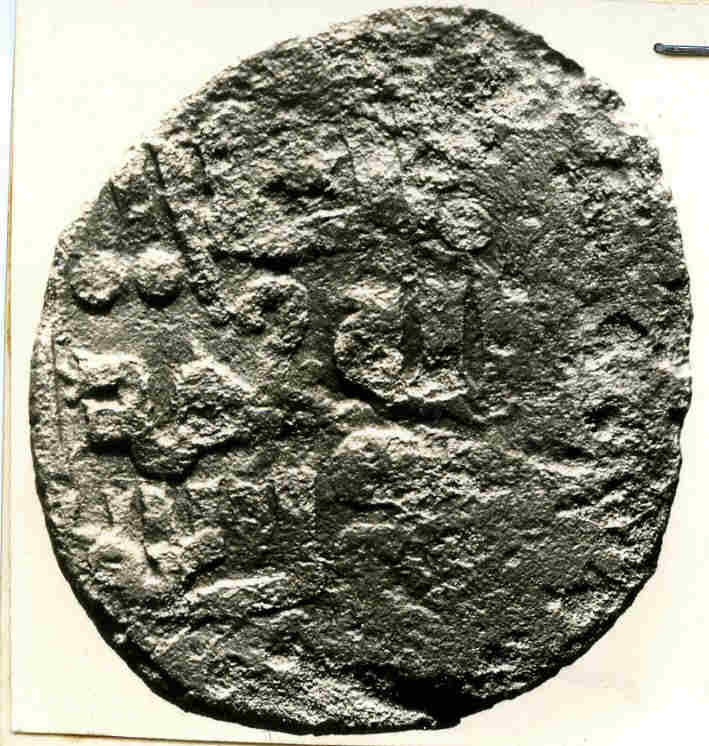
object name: coin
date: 1001-1300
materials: copper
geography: iran